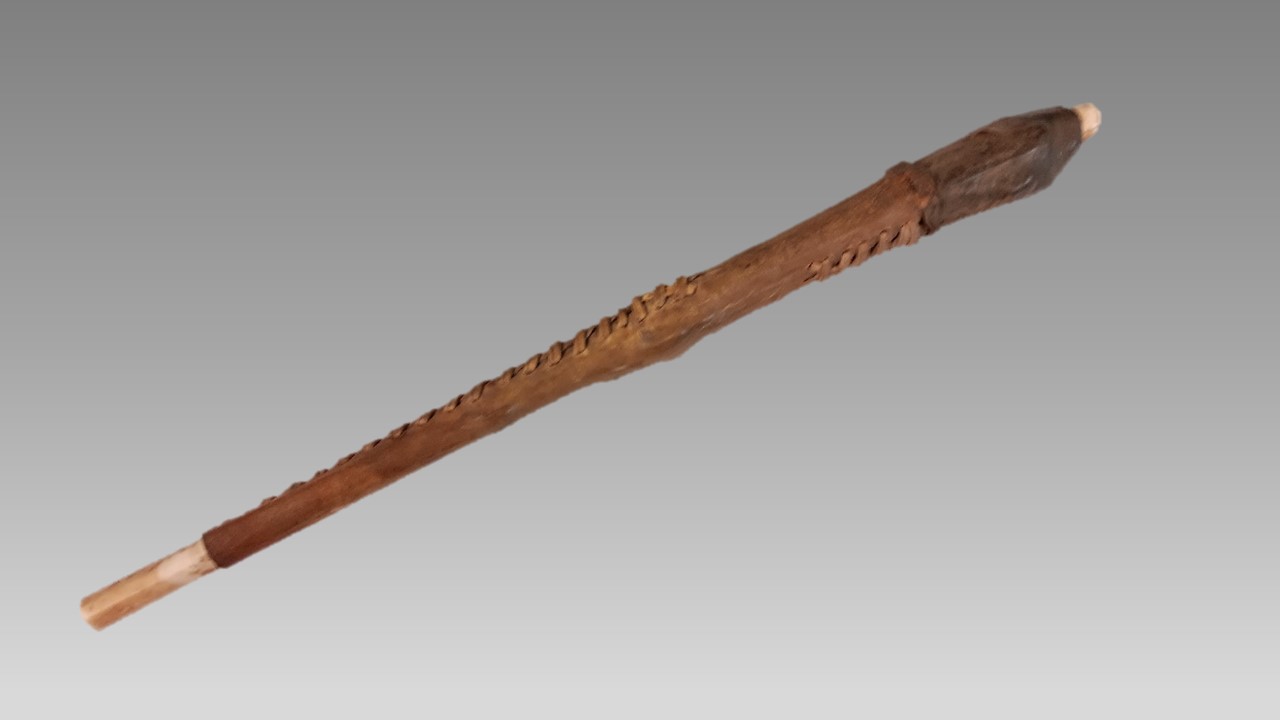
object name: whistle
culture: melanesian, bismarck archipelago or papua new guinean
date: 1867-1900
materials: bone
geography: papua new guinea